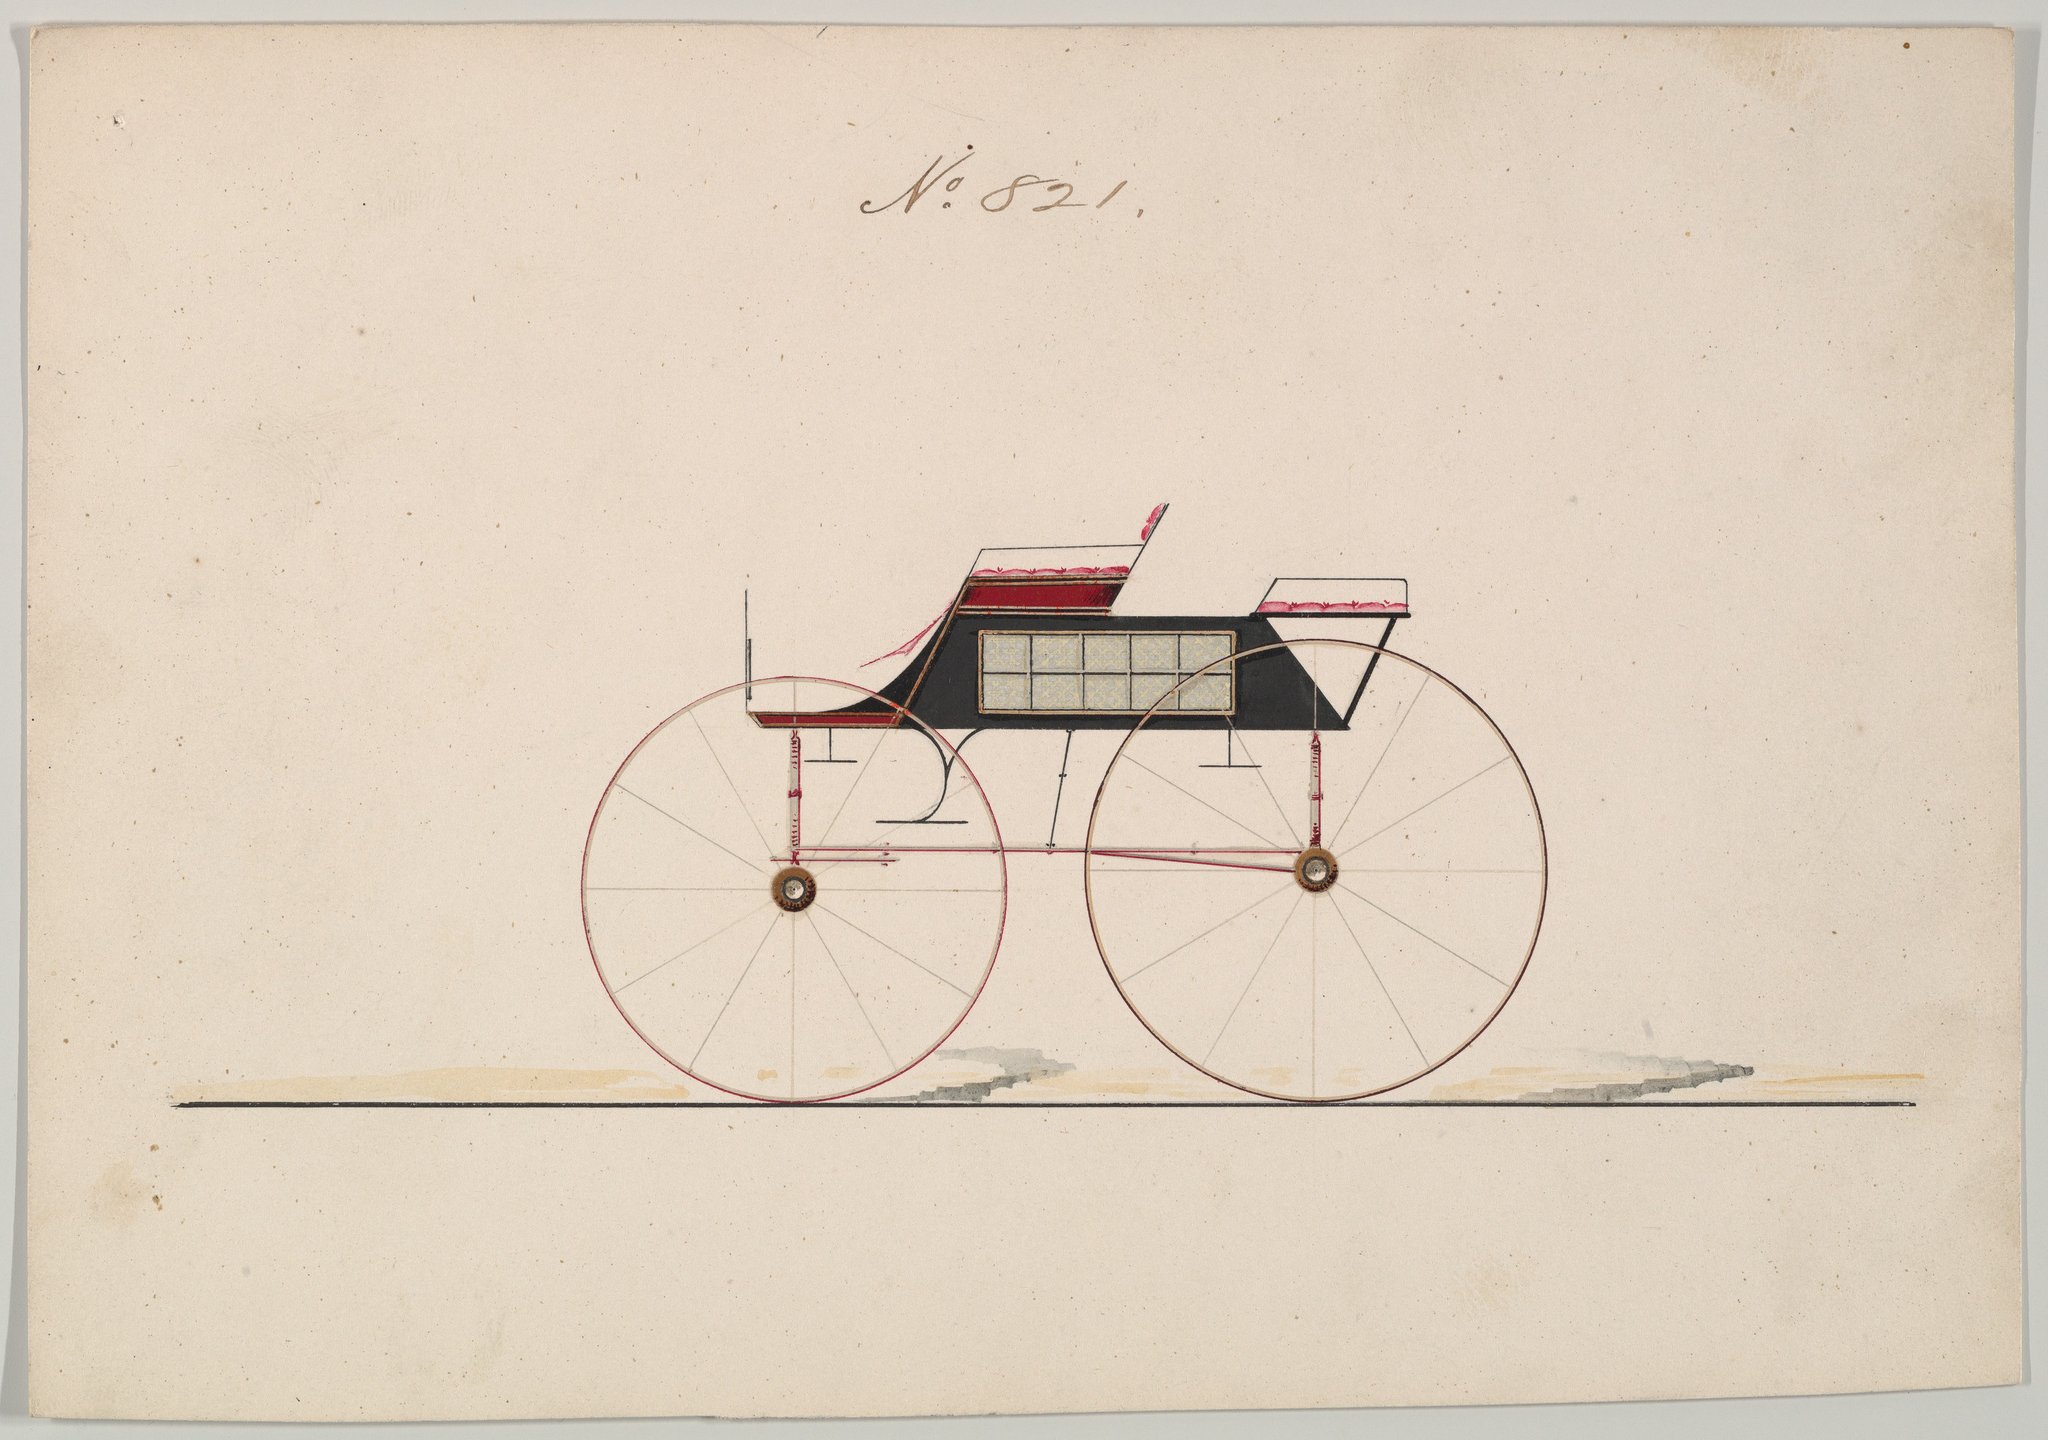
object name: drawing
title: Design for Wagon, no. 821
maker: brewster & co.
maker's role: manufacturer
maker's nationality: american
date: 1860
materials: gouache, gum arabic, ink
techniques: pen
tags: carriages